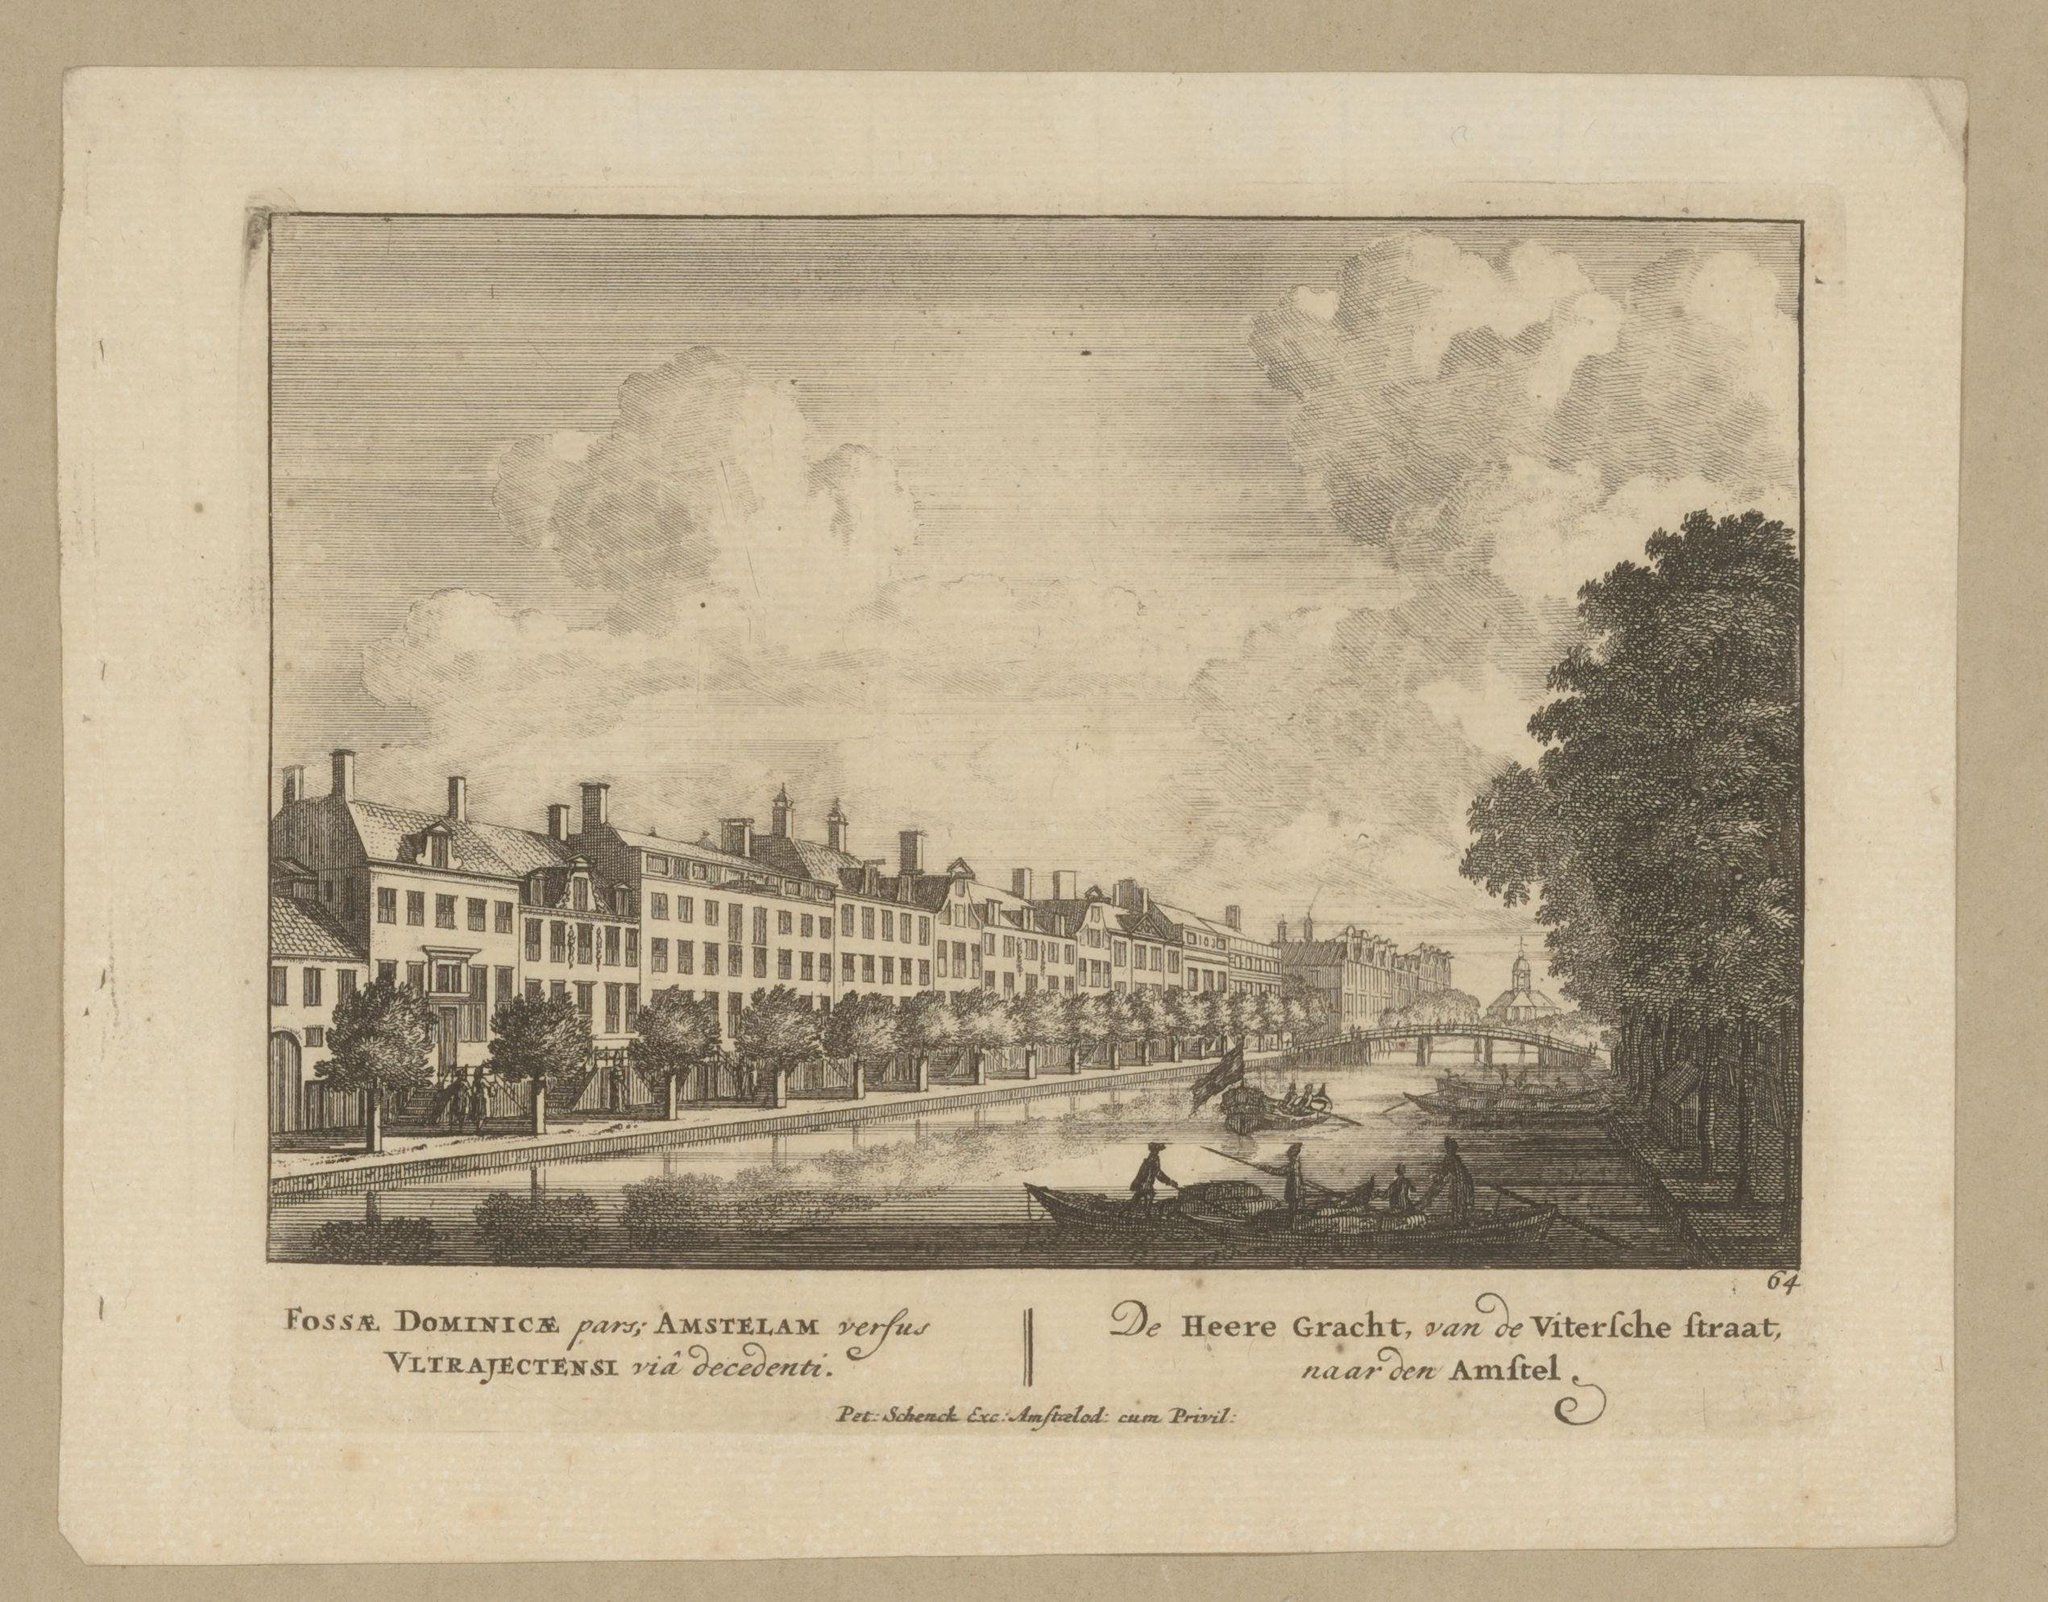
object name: print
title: De Heere Gracht, van de Uitersche straat, naar den Amstel / Fossae Dominicae pars; Amstelam versus Ultrajectensi viâ decedenti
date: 1694-1697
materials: paper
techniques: etching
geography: amsterdam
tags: city-view in general; 'veduta', canal, the usual house or row of houses, street, boat propelled by man or animal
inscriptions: collector's mark: ‘8,107’ Lugt 1641b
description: Prent ook gebruikt in: Admirandorum Quadruplex Spectaculum. Amsterdam: Pieter Schenk (I), s.a. [1694-1697].* * De titelprent, opdracht en het portret van Frederik van Saksen zijn gegraveerd door Pieter Schenk (I). De overige prenten uit deze serie zijn, zoals aangegeven op de titelprent, van de hand van Jan van Call (I).